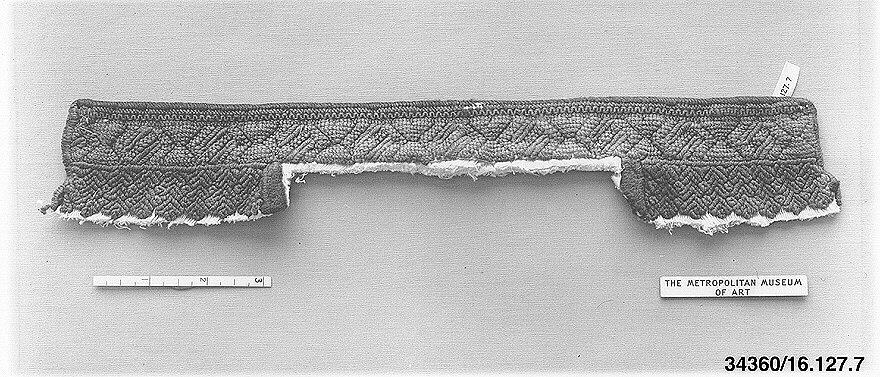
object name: collar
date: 1801-1900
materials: wool